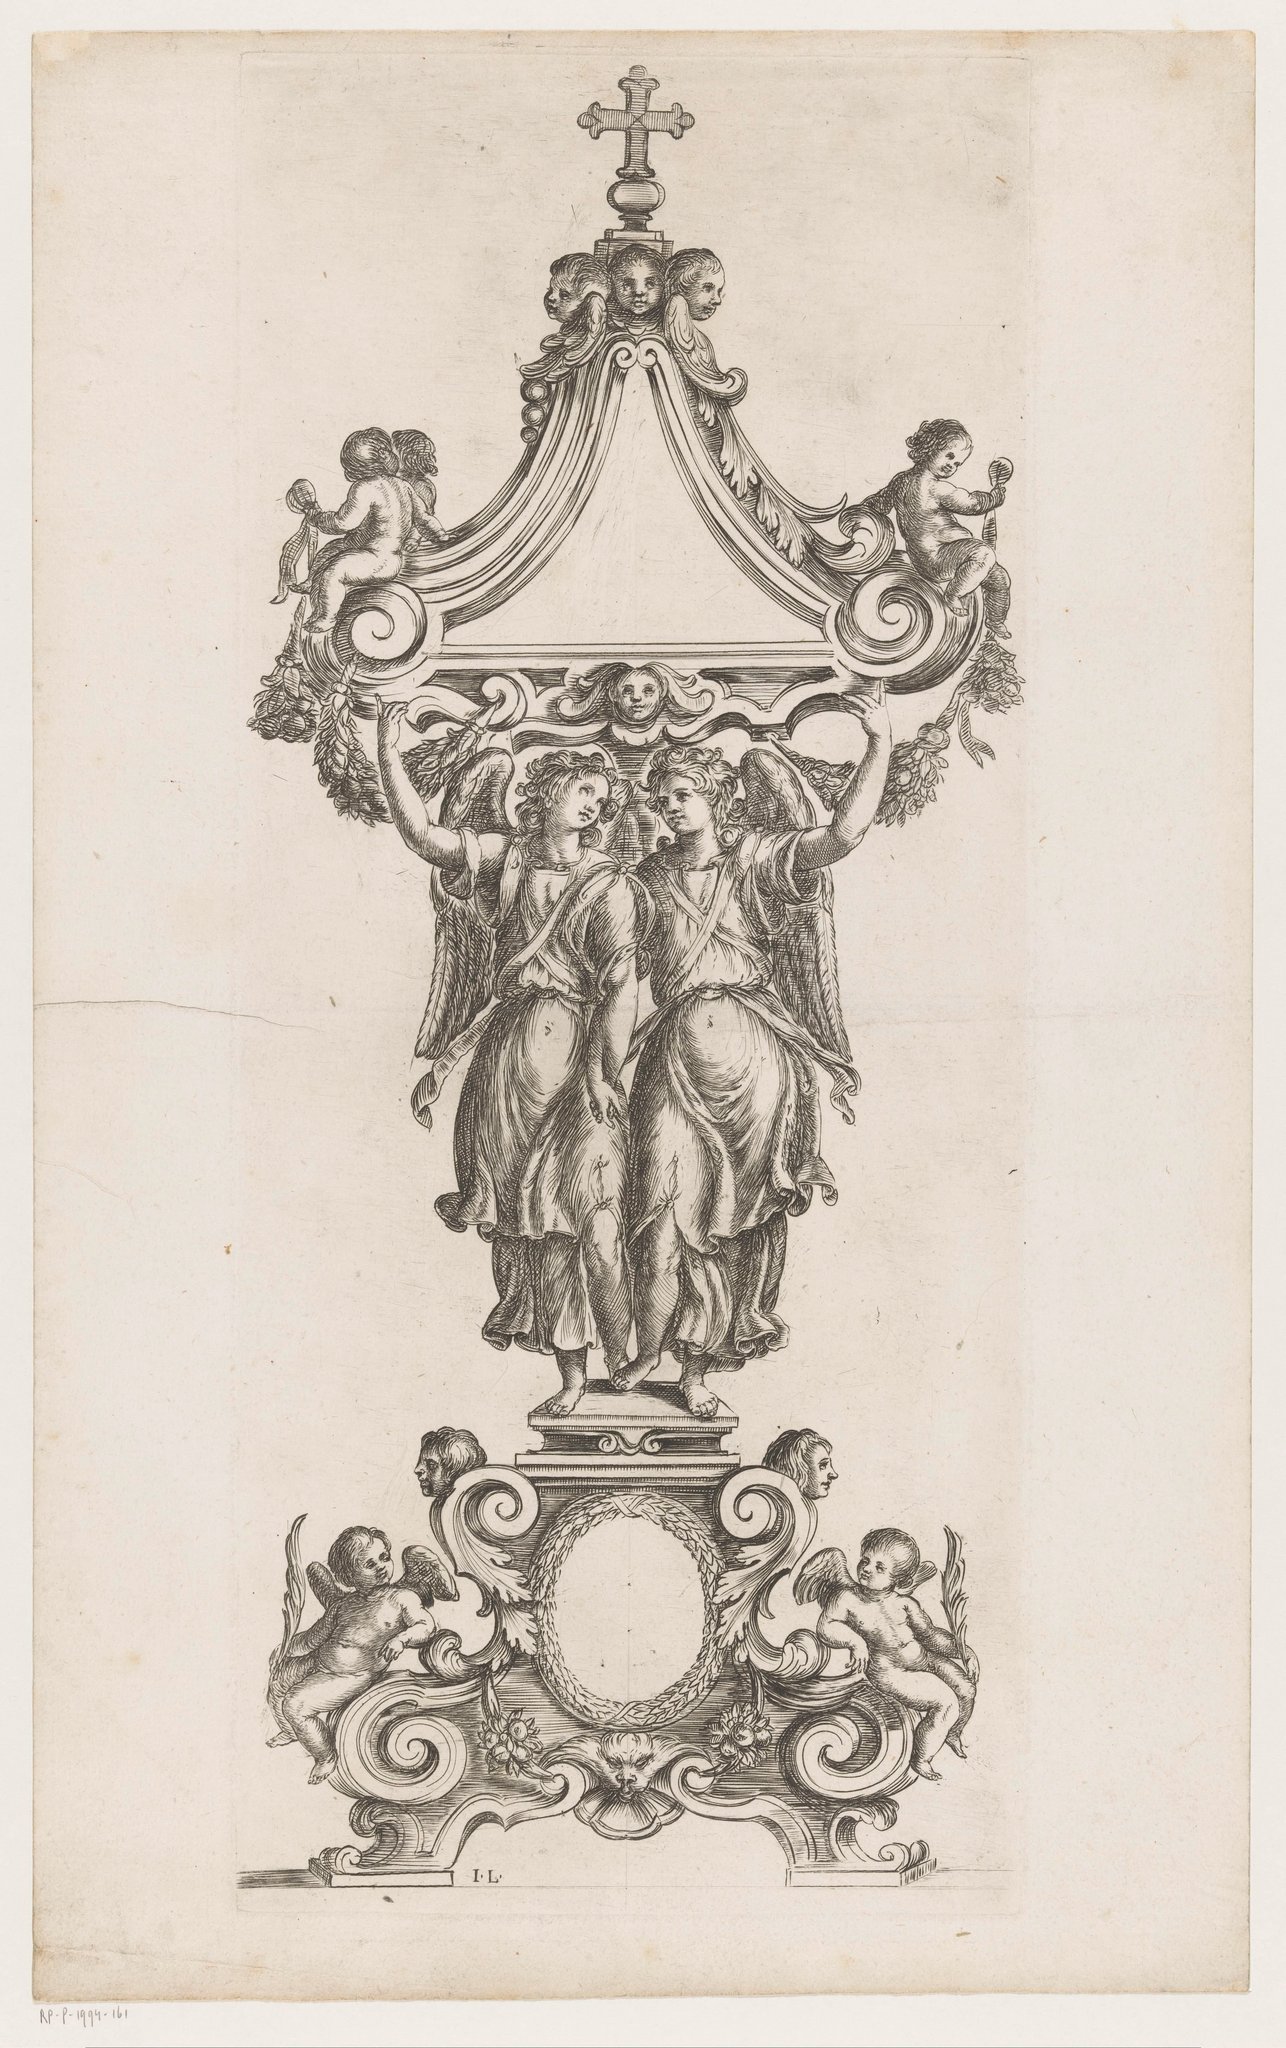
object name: ornament print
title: Monstransen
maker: giacomo laurenziani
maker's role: print maker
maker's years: 1600-1650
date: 1637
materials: paper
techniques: etching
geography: italy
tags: ostensorium, monstrance, cupids: 'amores', 'amoretti', 'putti'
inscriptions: collector's mark: Lugt 2228, collector's mark: Lugt 2760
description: Een monstrans met steel in de vorm van twee engelen die het bovenste, driehoekige gedeelte van de monstrans dragen. De driehoek wordt geflankeerd door putti en bekroond door cherubijnen en een crucifix. De voet van de monstrans is gedecoreerd met putti met palmtakken en engelenkopjes. In het midden een leeg vignet.